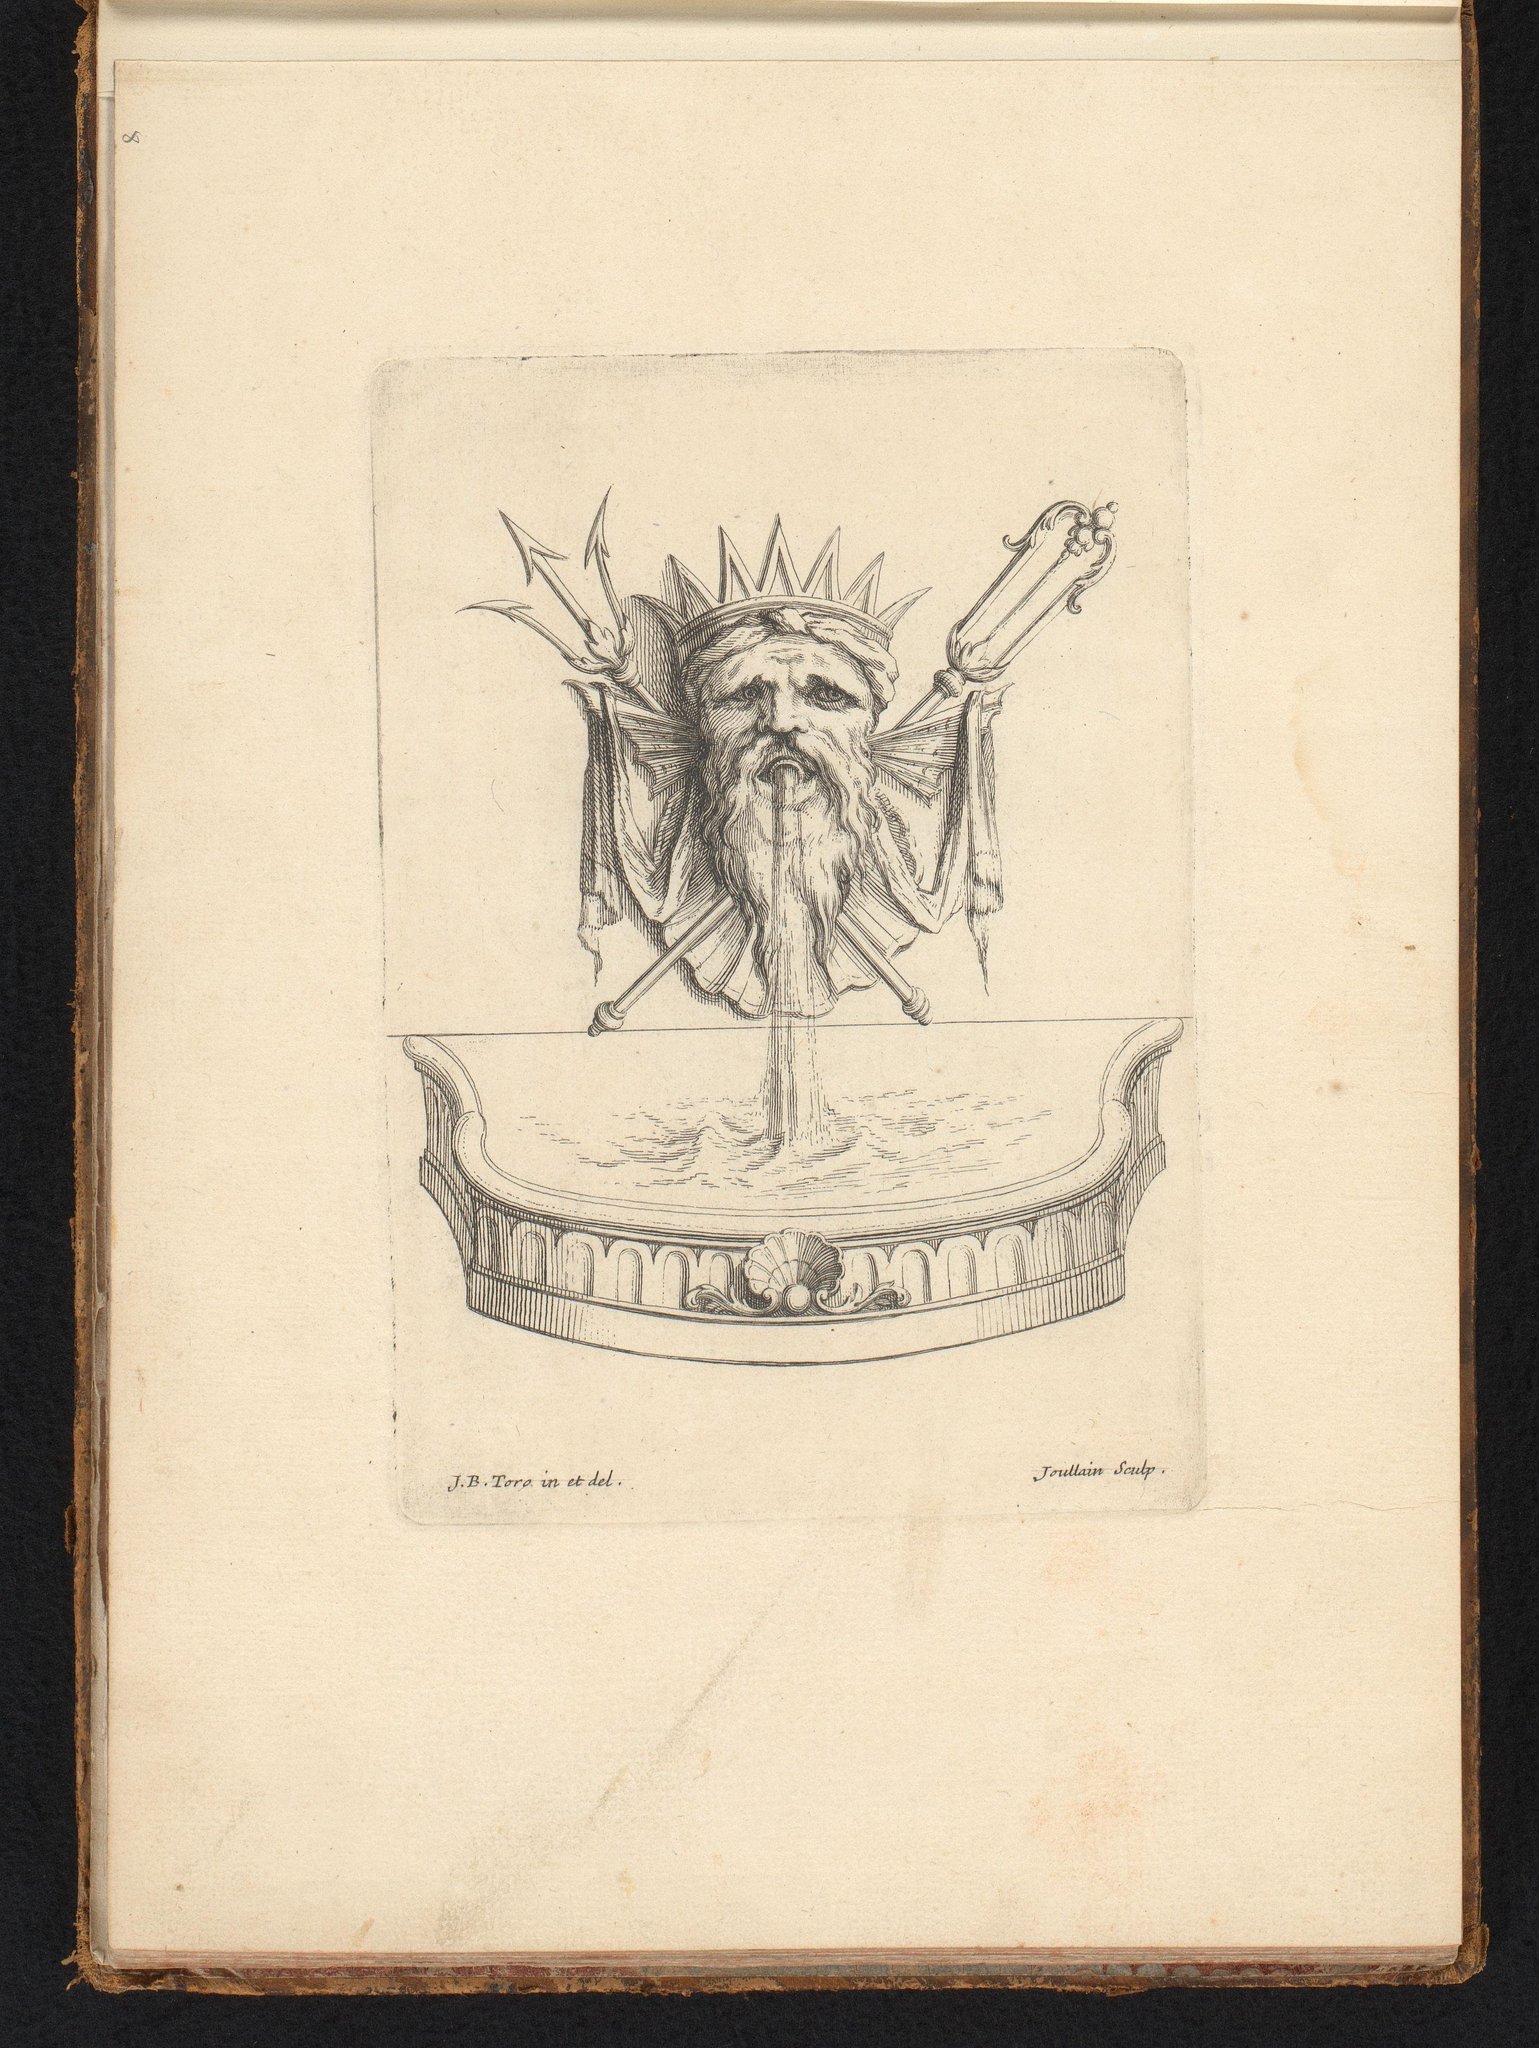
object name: album leaf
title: Fontein met Neptunus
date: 1682-1731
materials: paper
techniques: etching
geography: paris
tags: (story of) neptune (poseidon), water-works in garden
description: Prent maakt deel uit van een serie van zes prenten.